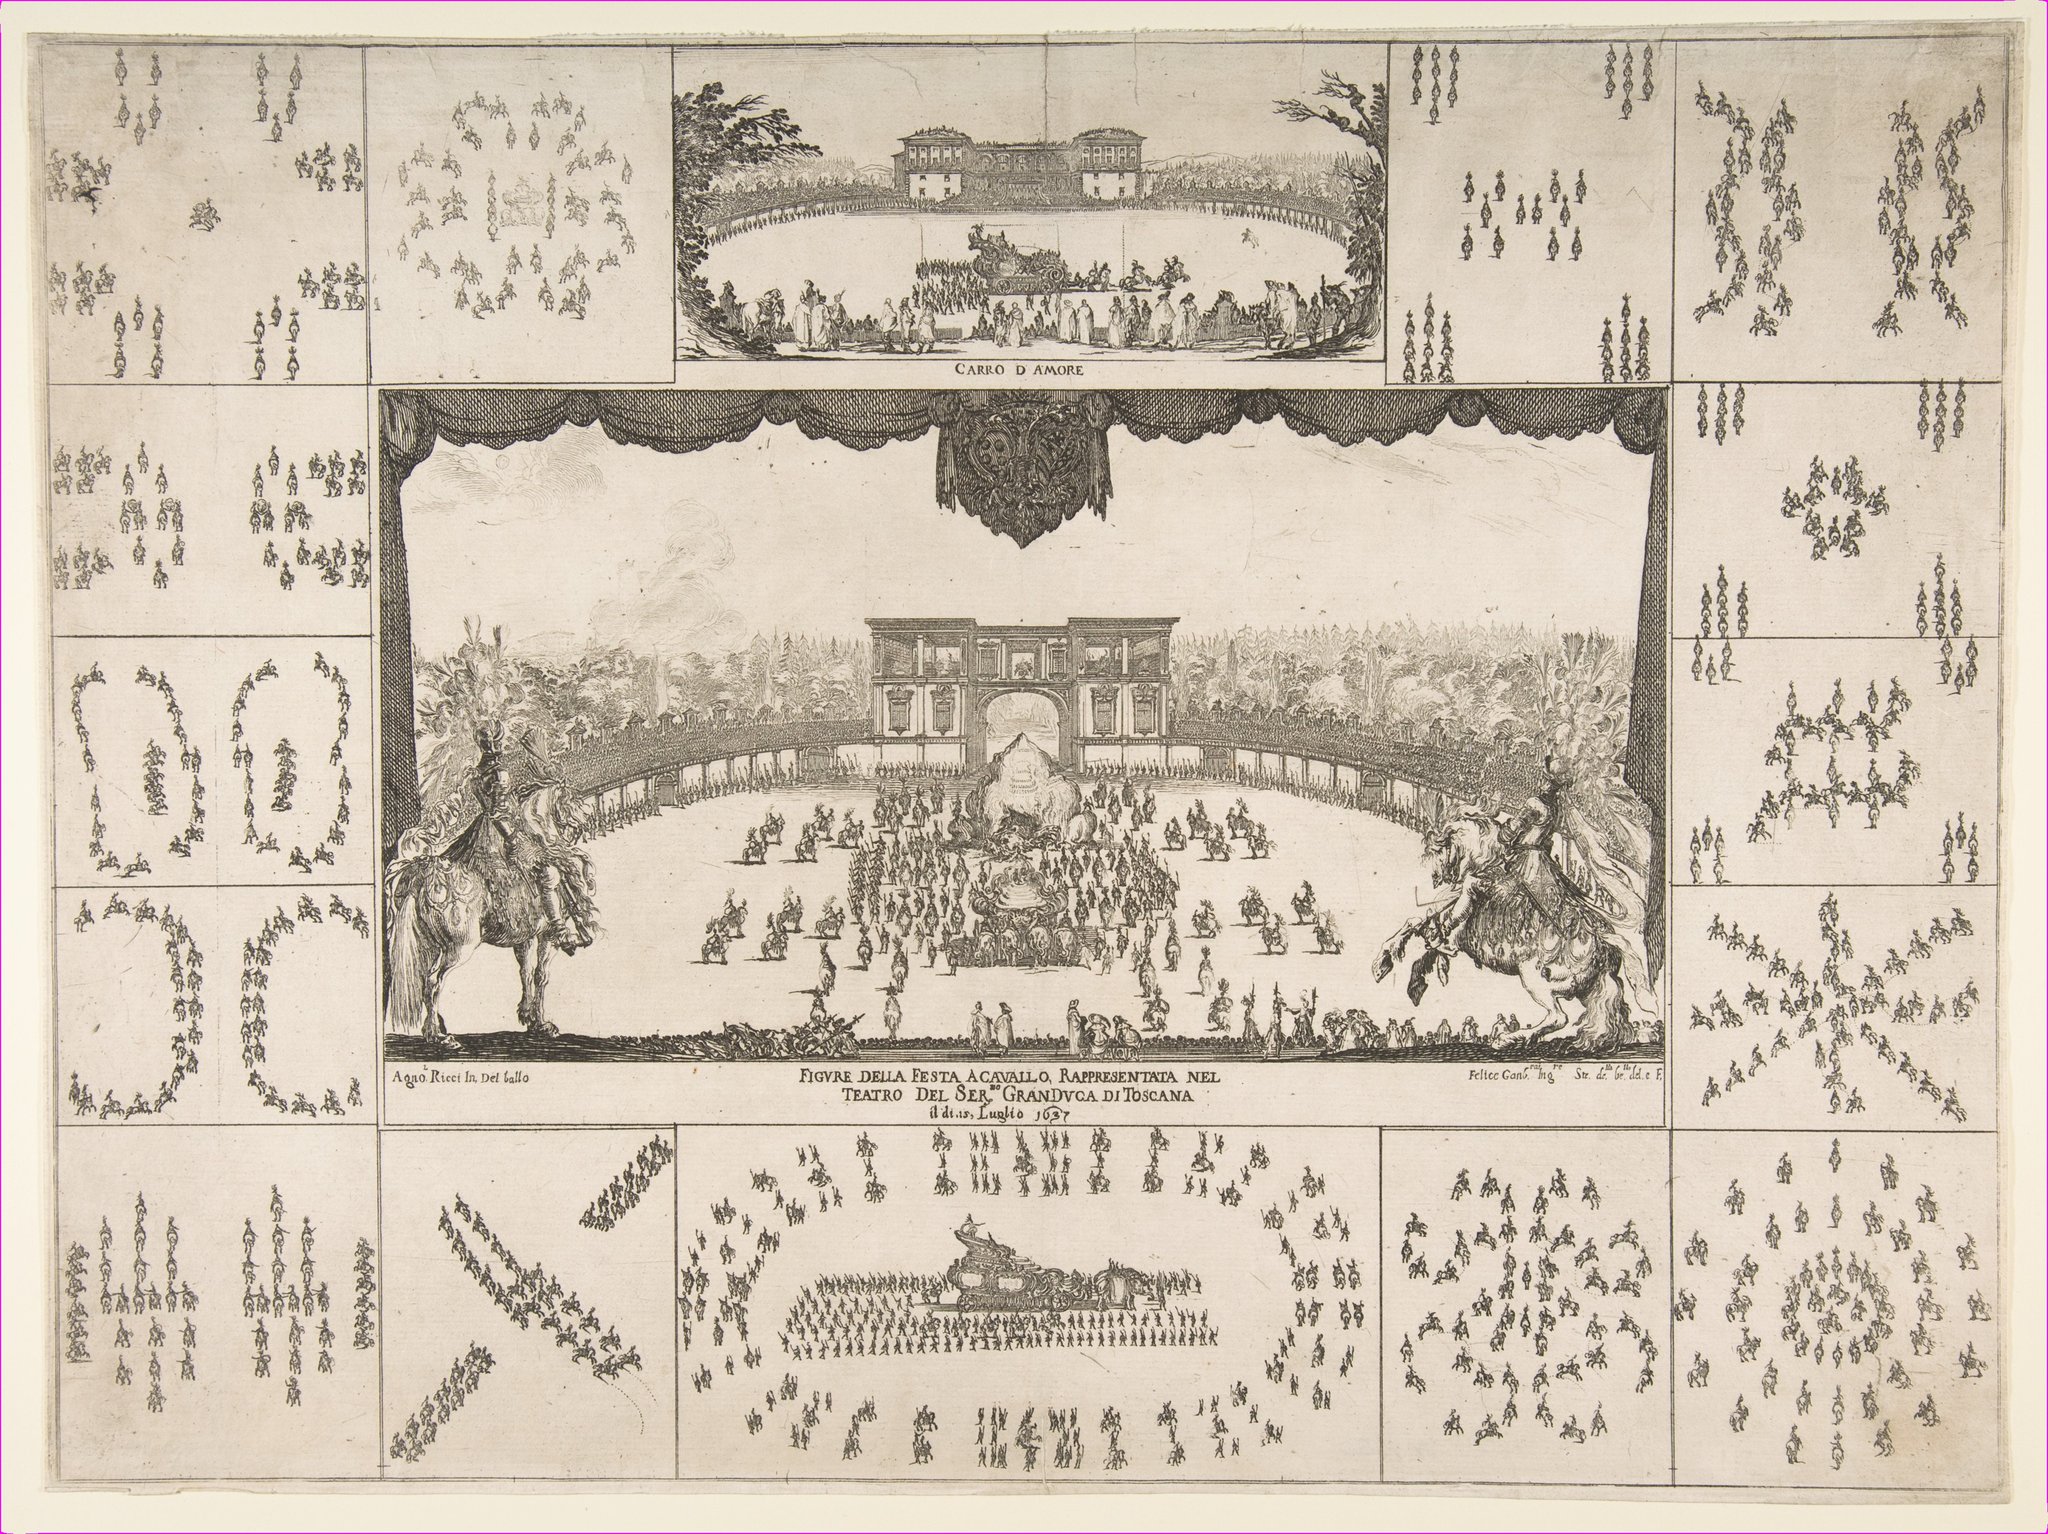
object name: print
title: Carousel in Florence for the Marriage of The Grand Duke Ferdinand II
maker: stefano della bella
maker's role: artist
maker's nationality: italian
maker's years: 1610-1664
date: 1637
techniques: etching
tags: human figures